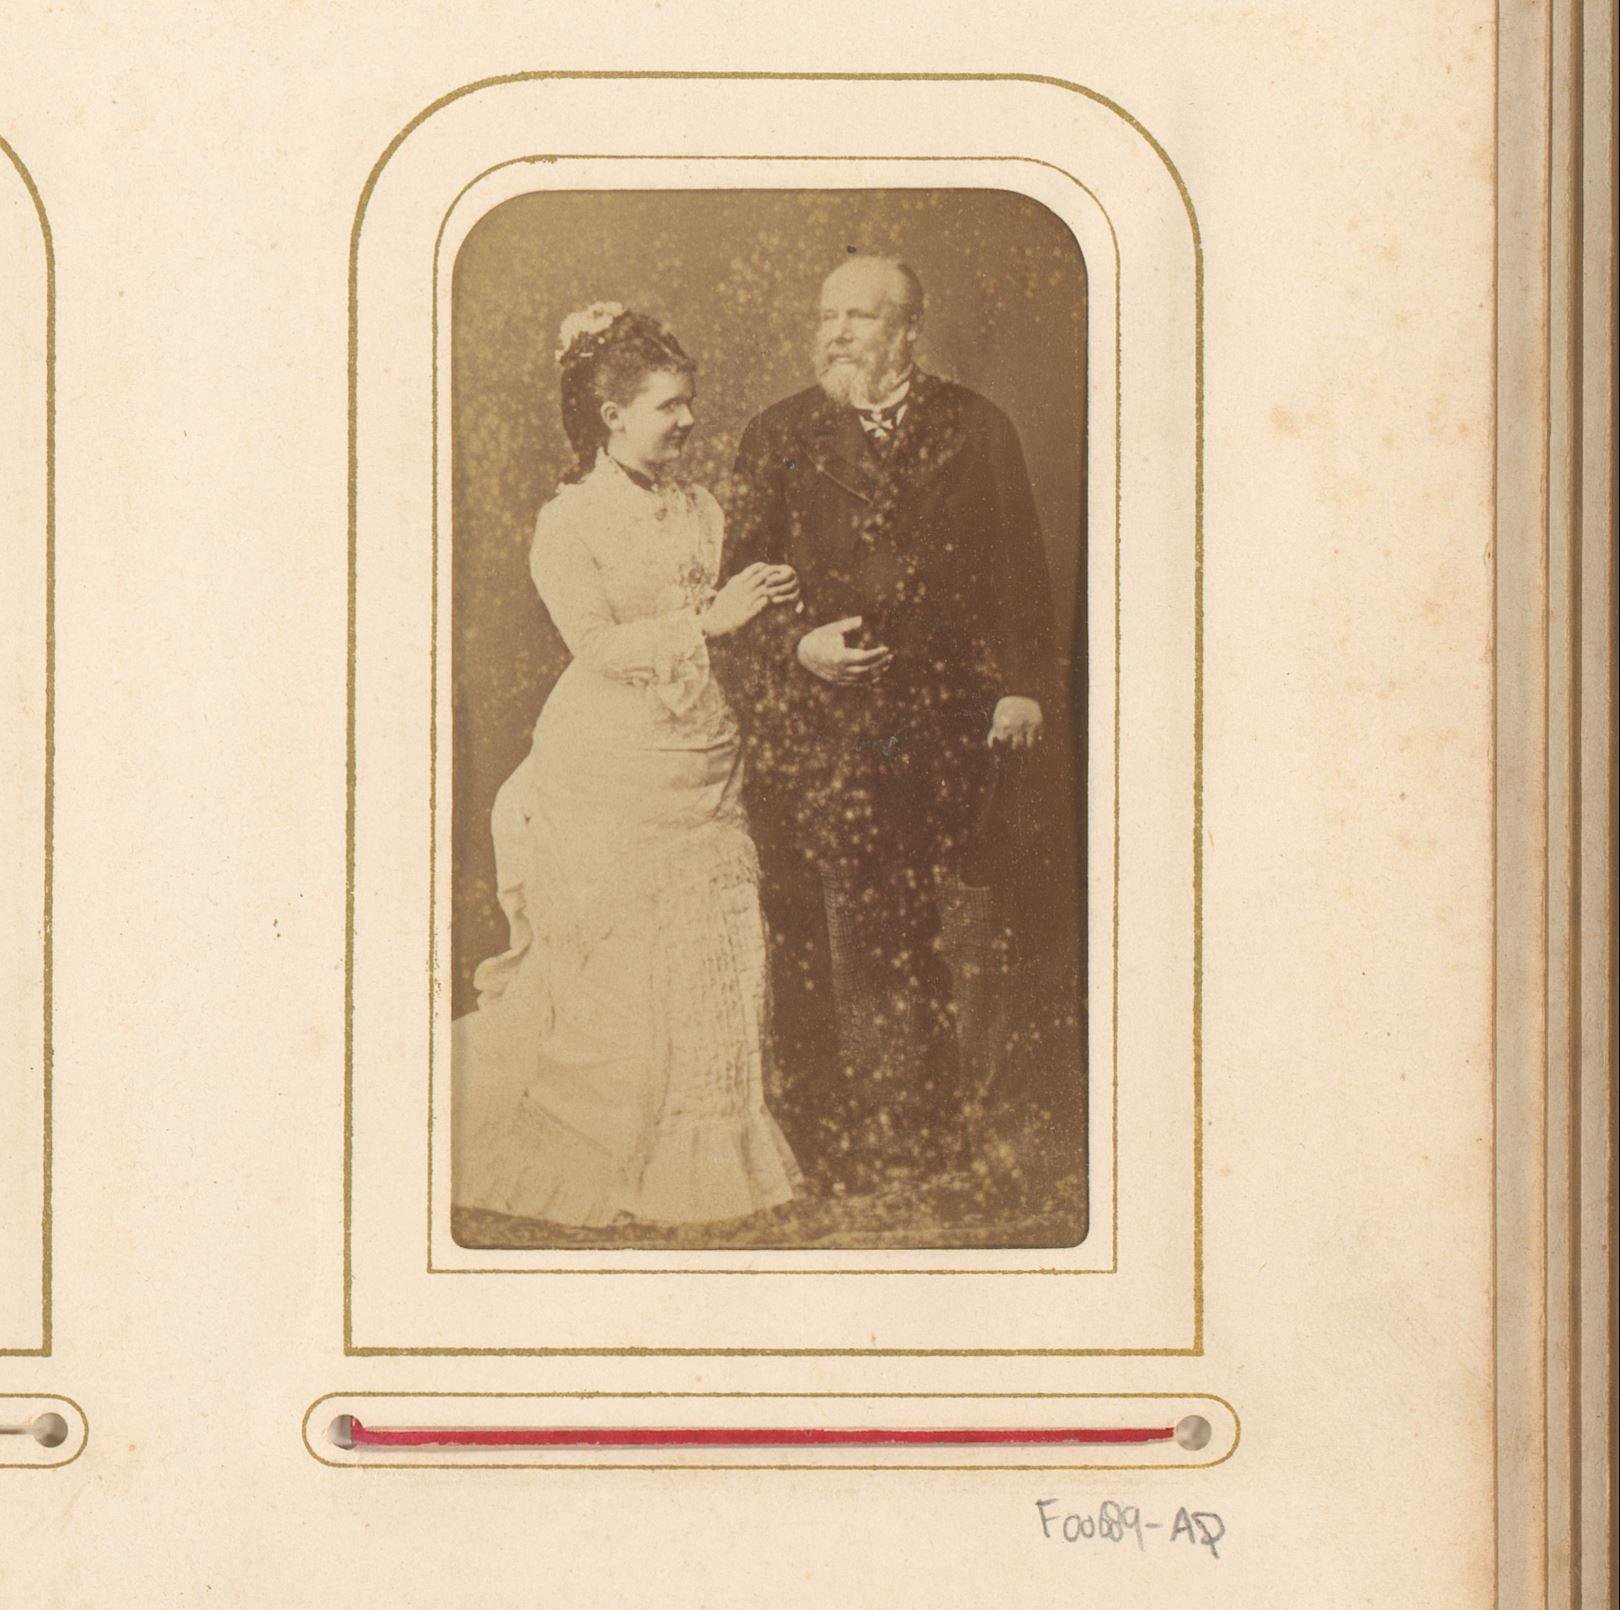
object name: album leaf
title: Portret van Willem III en Emma, koning en koningin der Nederlanden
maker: Anonymous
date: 1875-1890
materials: cardboard, photographic support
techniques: albumen print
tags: emma (queen consort of the netherlands), brussels, willem iii (koning der nederlanden), historical persons - bb - woman, historical persons, ruler, sovereign - bb - female ruler, ruler, sovereign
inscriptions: inscription: ‘HH. MM. de Koning en Koningin der Nederlanden’